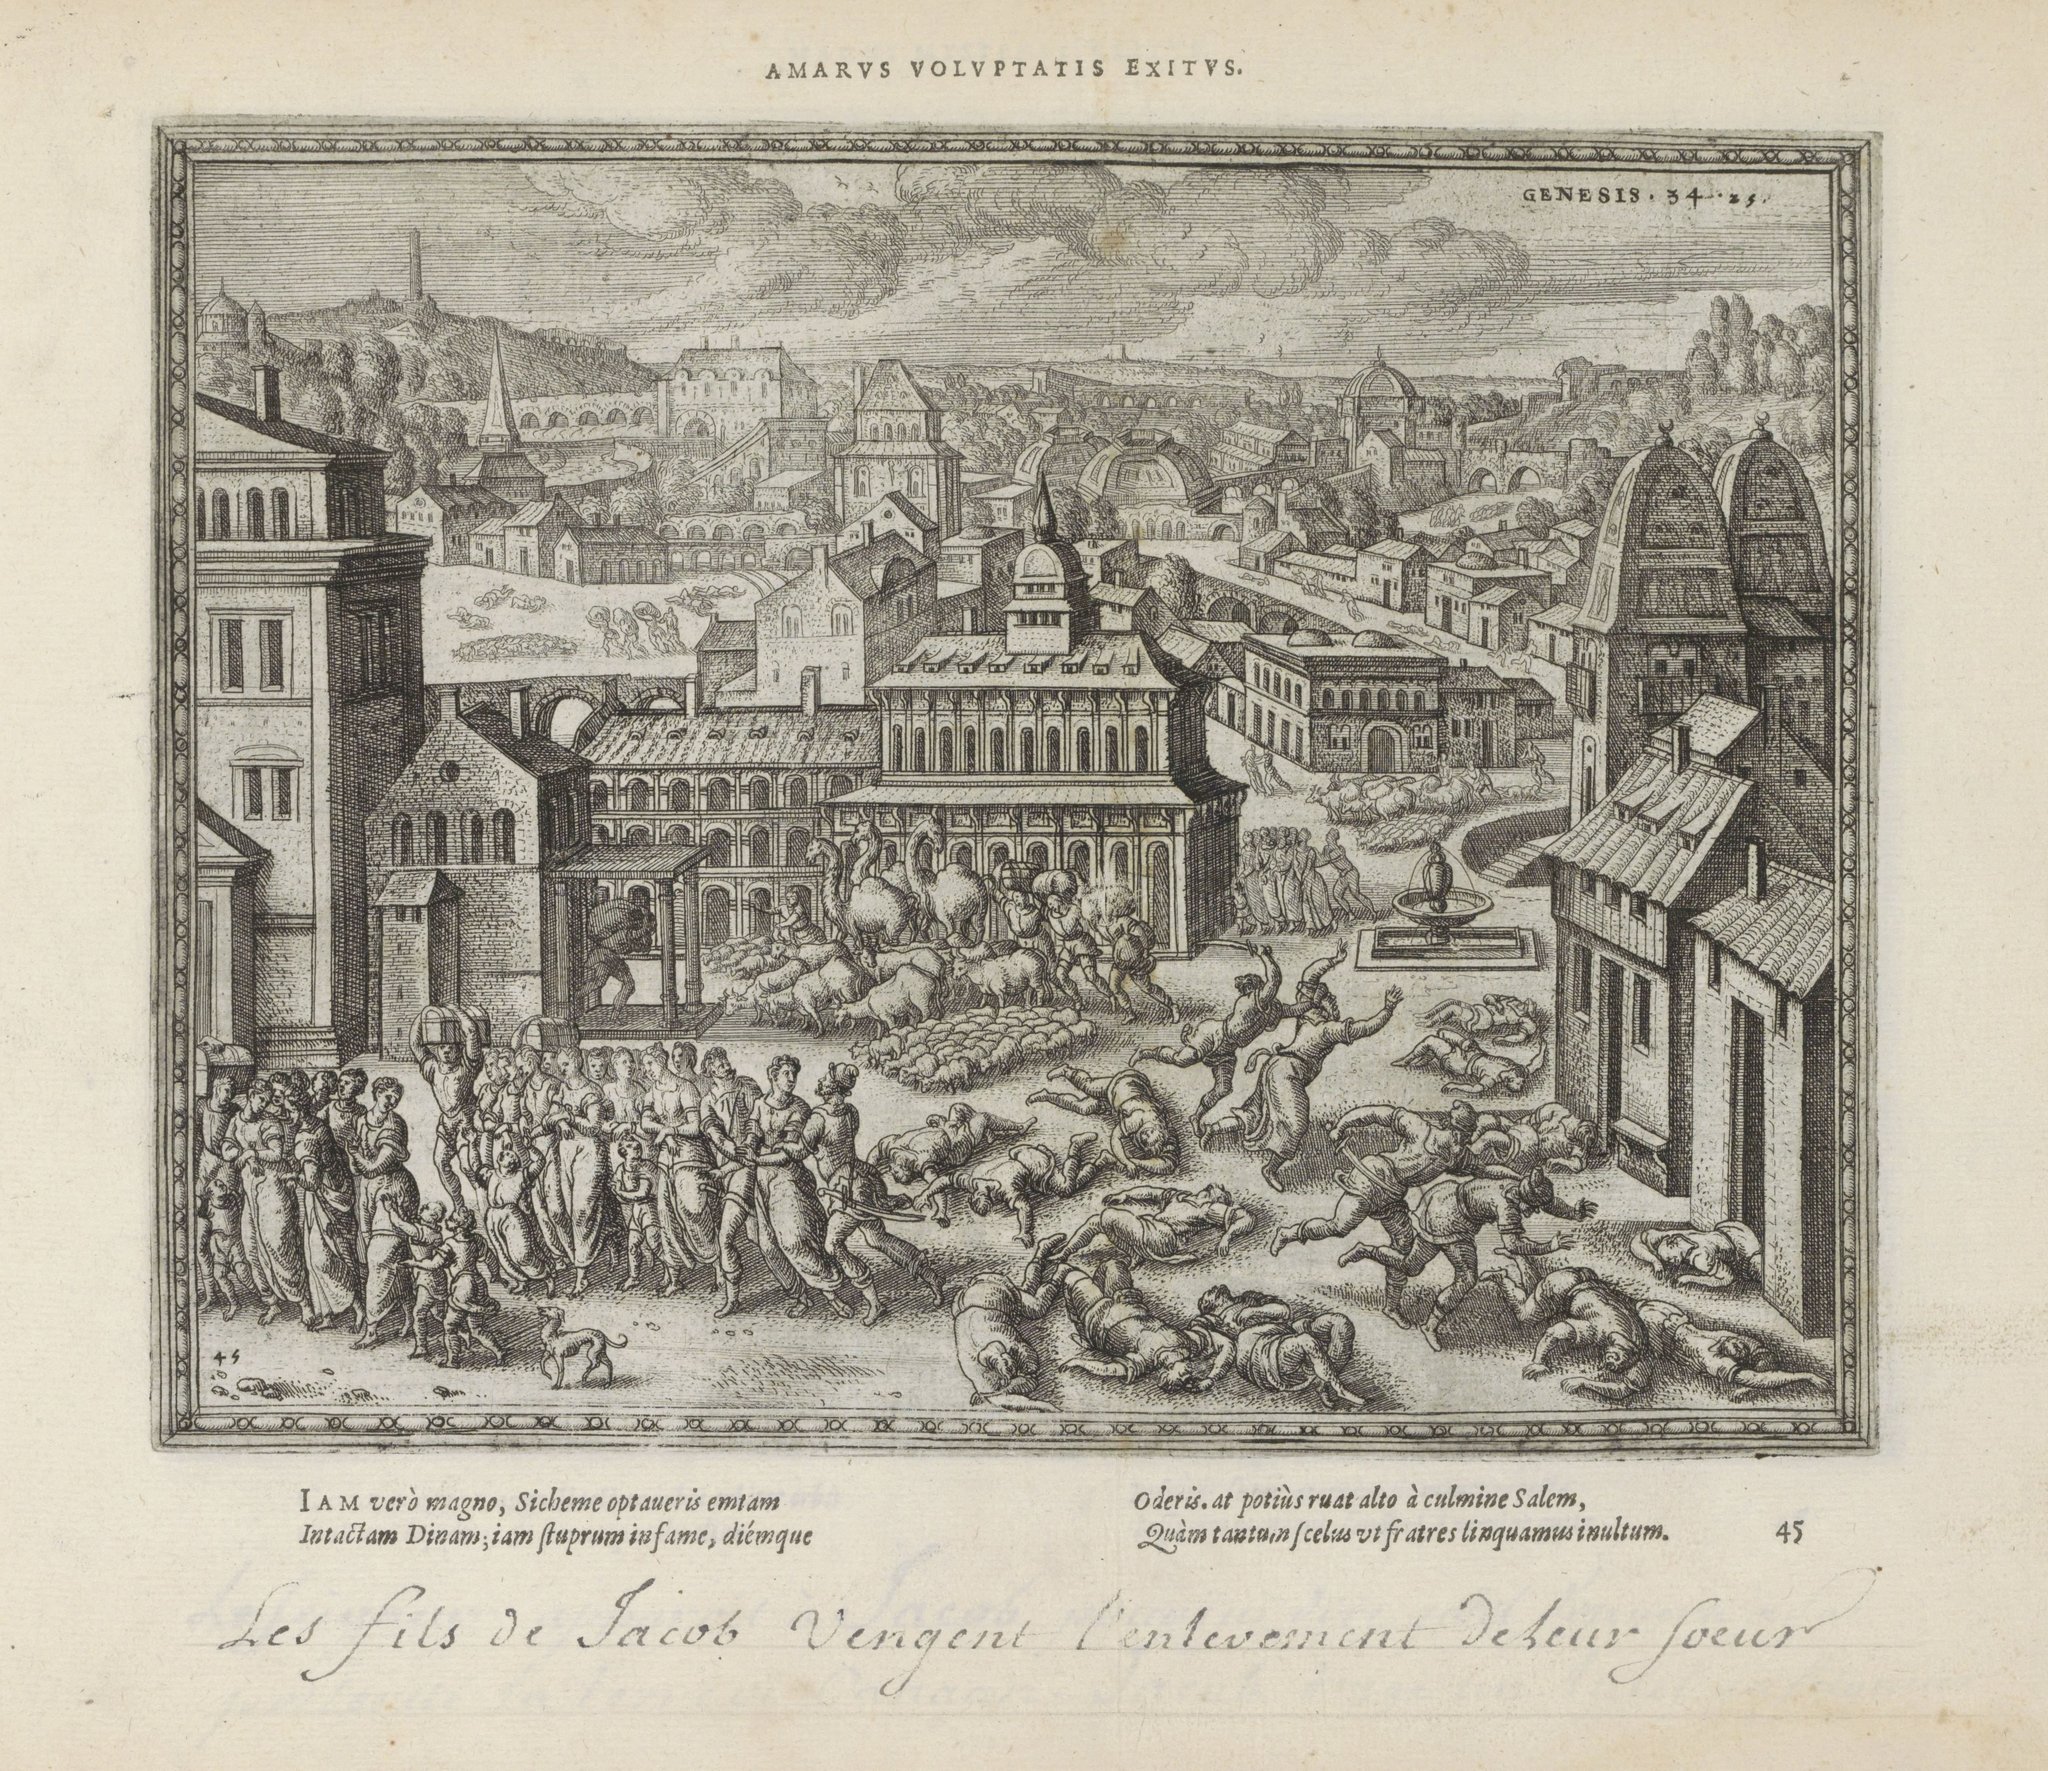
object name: album leaf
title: Amarus voluptatis exitus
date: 1582-1593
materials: paper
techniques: etching, letterpress printing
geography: antwerp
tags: simeon and levi kill all the shechemites and bring dinah home, while the other brothers plunder the city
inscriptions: inscription: ‘Les fils de Jacob vengent l'enlevement de leur soeur’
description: Stadsgezicht. Links nemen Simeon en Levi hun zus Dina mee naar huis, nadat zij wraak hebben genomen op Sichem die hun zus had onteerd (Gen. 34:25). Met een motto in het Latijn boven de voorstelling en een vierregelig onderschrift in het Latijn onder de prent. De prent maakt deel uit van een album.